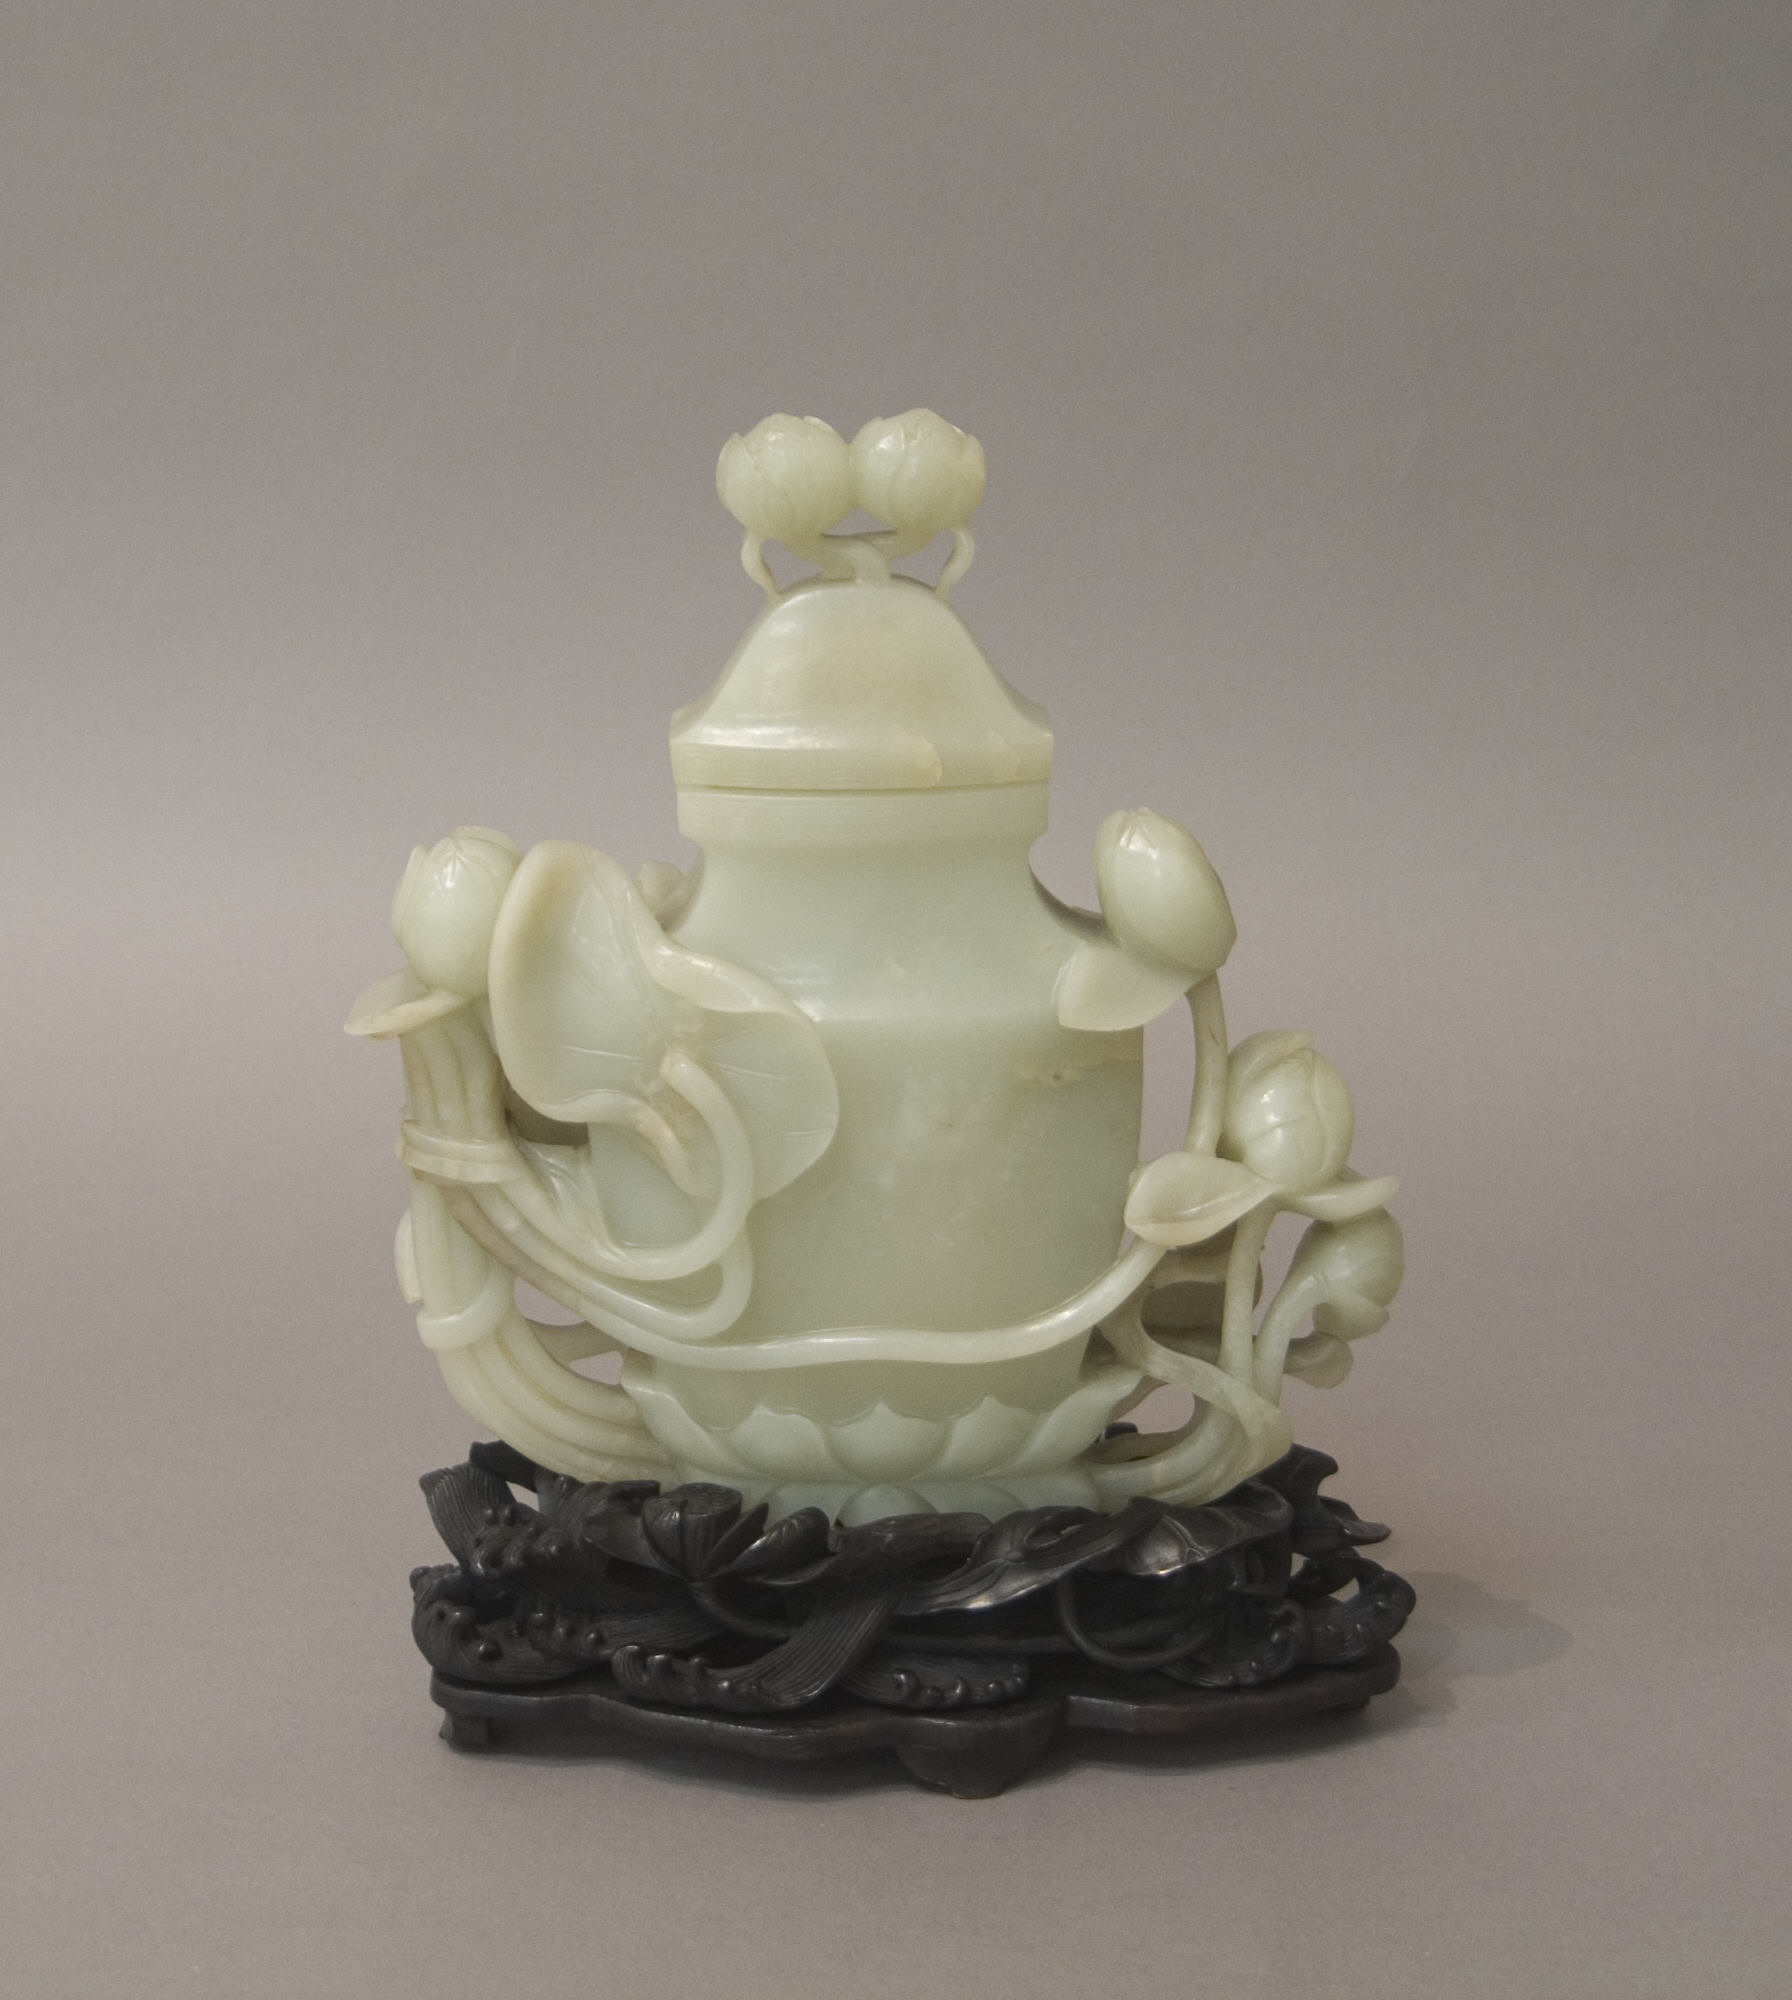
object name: vase with cover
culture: chinese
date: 1662-1722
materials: jade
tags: flowers